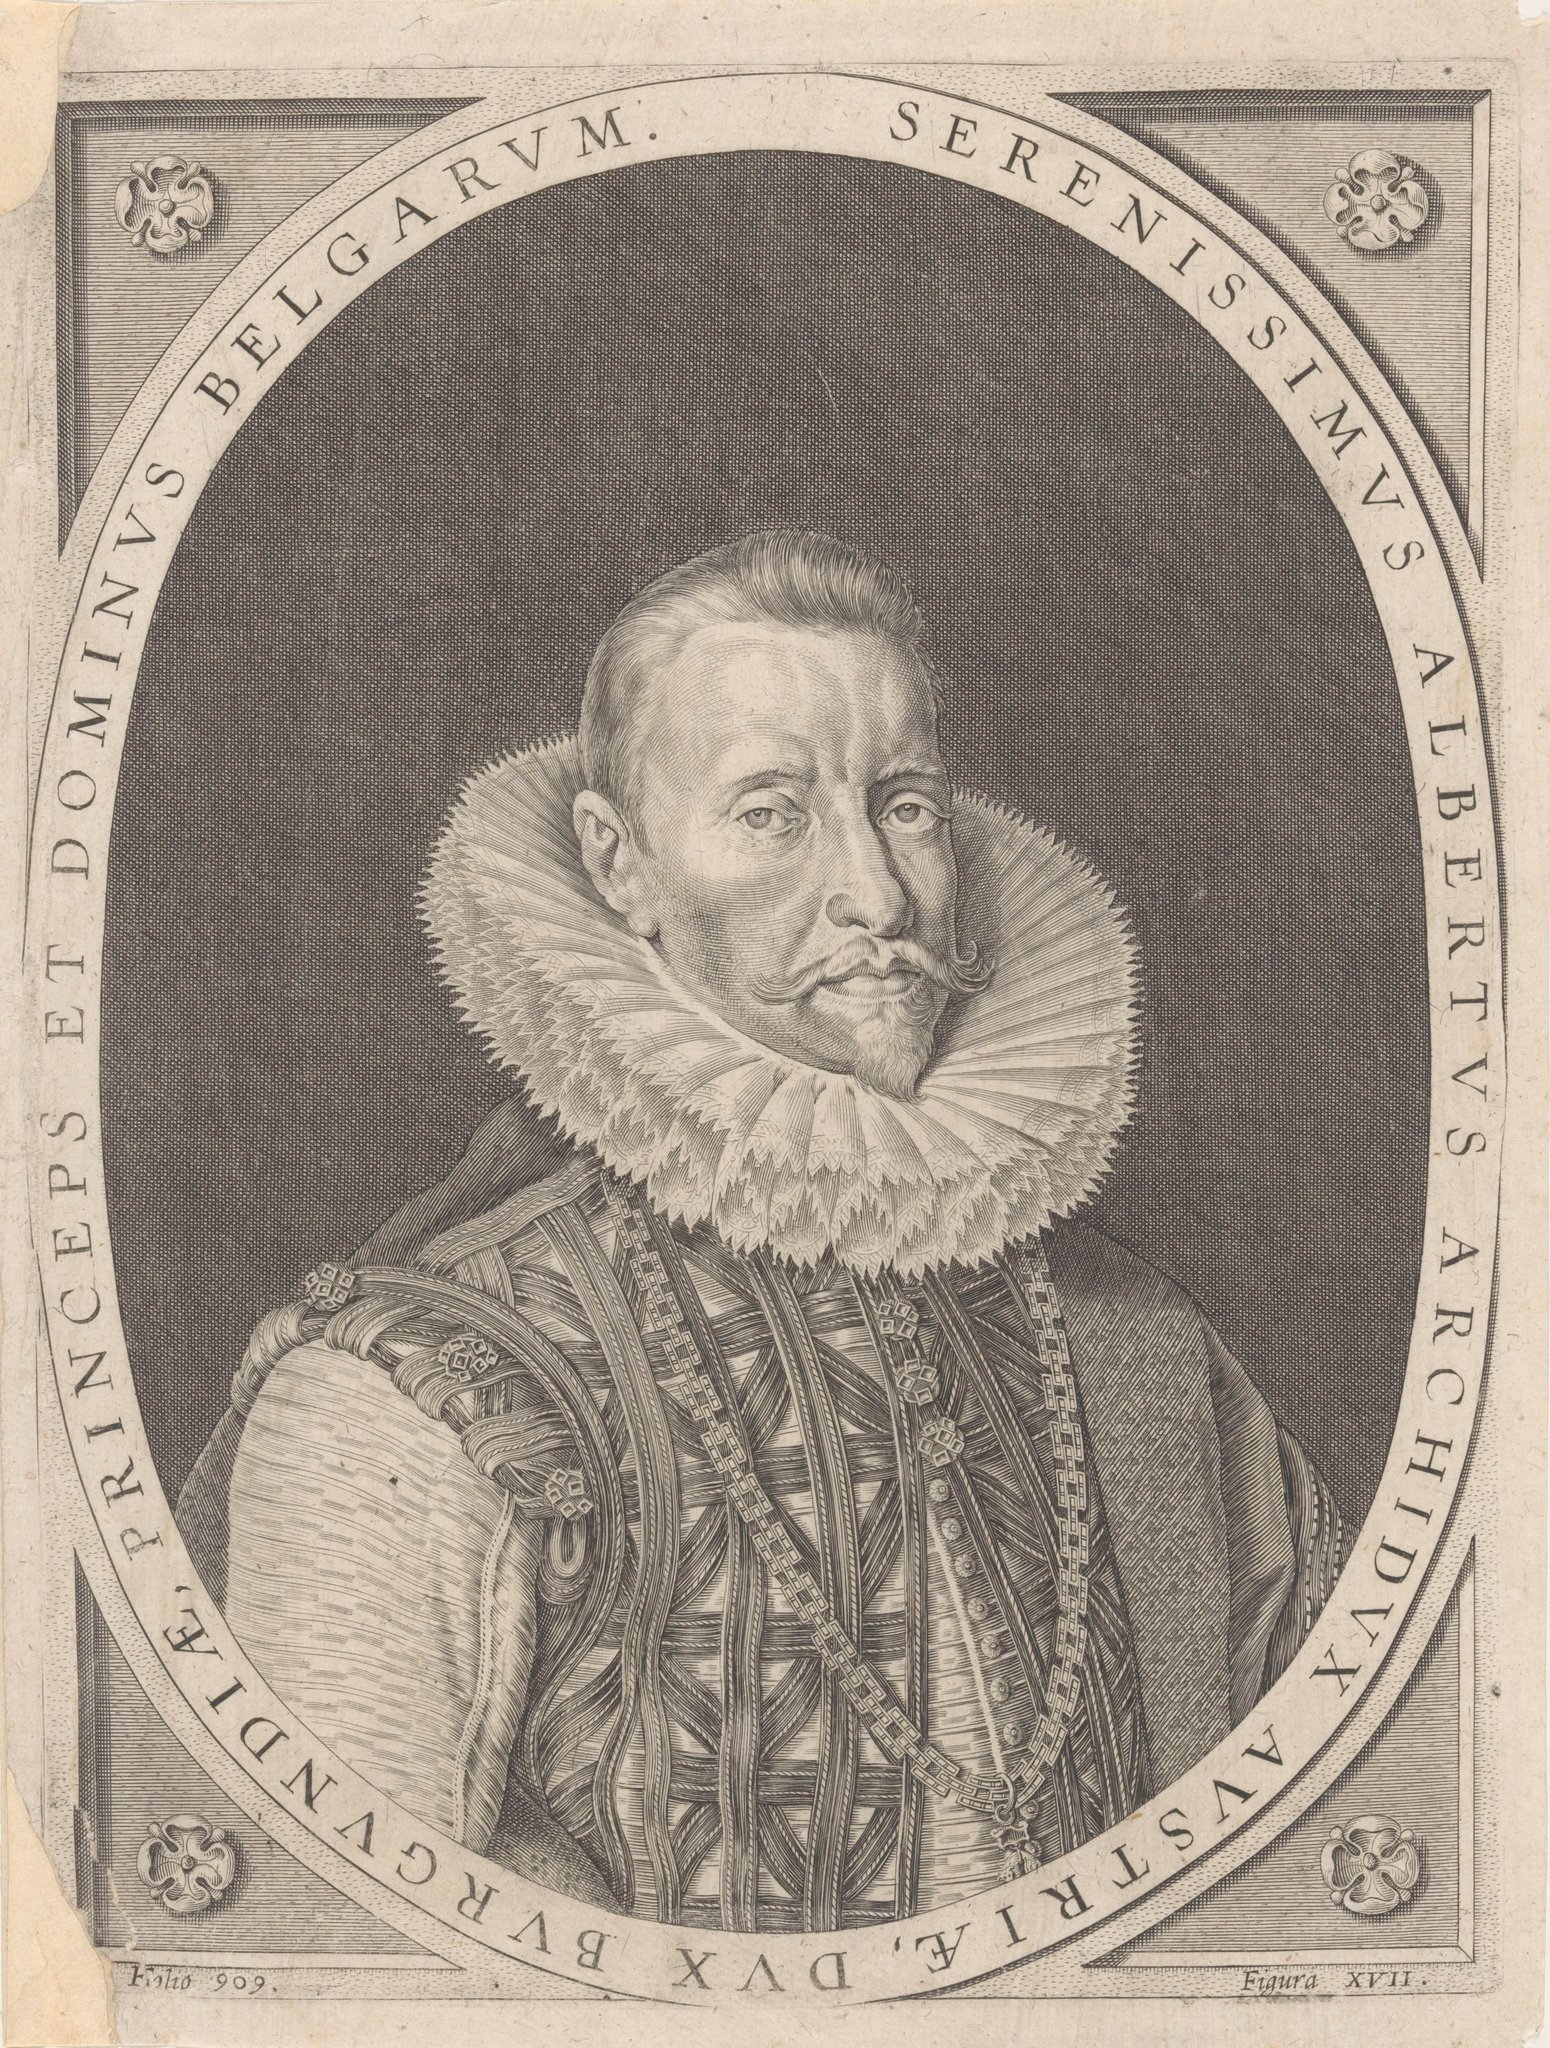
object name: print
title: Portret van Albrecht, aartshertog van Oostenrijk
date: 1620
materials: paper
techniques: engraving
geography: antwerp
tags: brussels, albrecht aartshertog van oostenrijk, knighthood order of the golden fleece - insignia of a knighthood order, e.g.: badge, chain (with name of order)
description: Prent uit: Meerbeeck, Adriaen van. Chroniicke vande gantsche vverelt, ende sonderlinghe vande seventhien Nederlanden. Antwerpen: Hieronymus Verdussen, 1620.